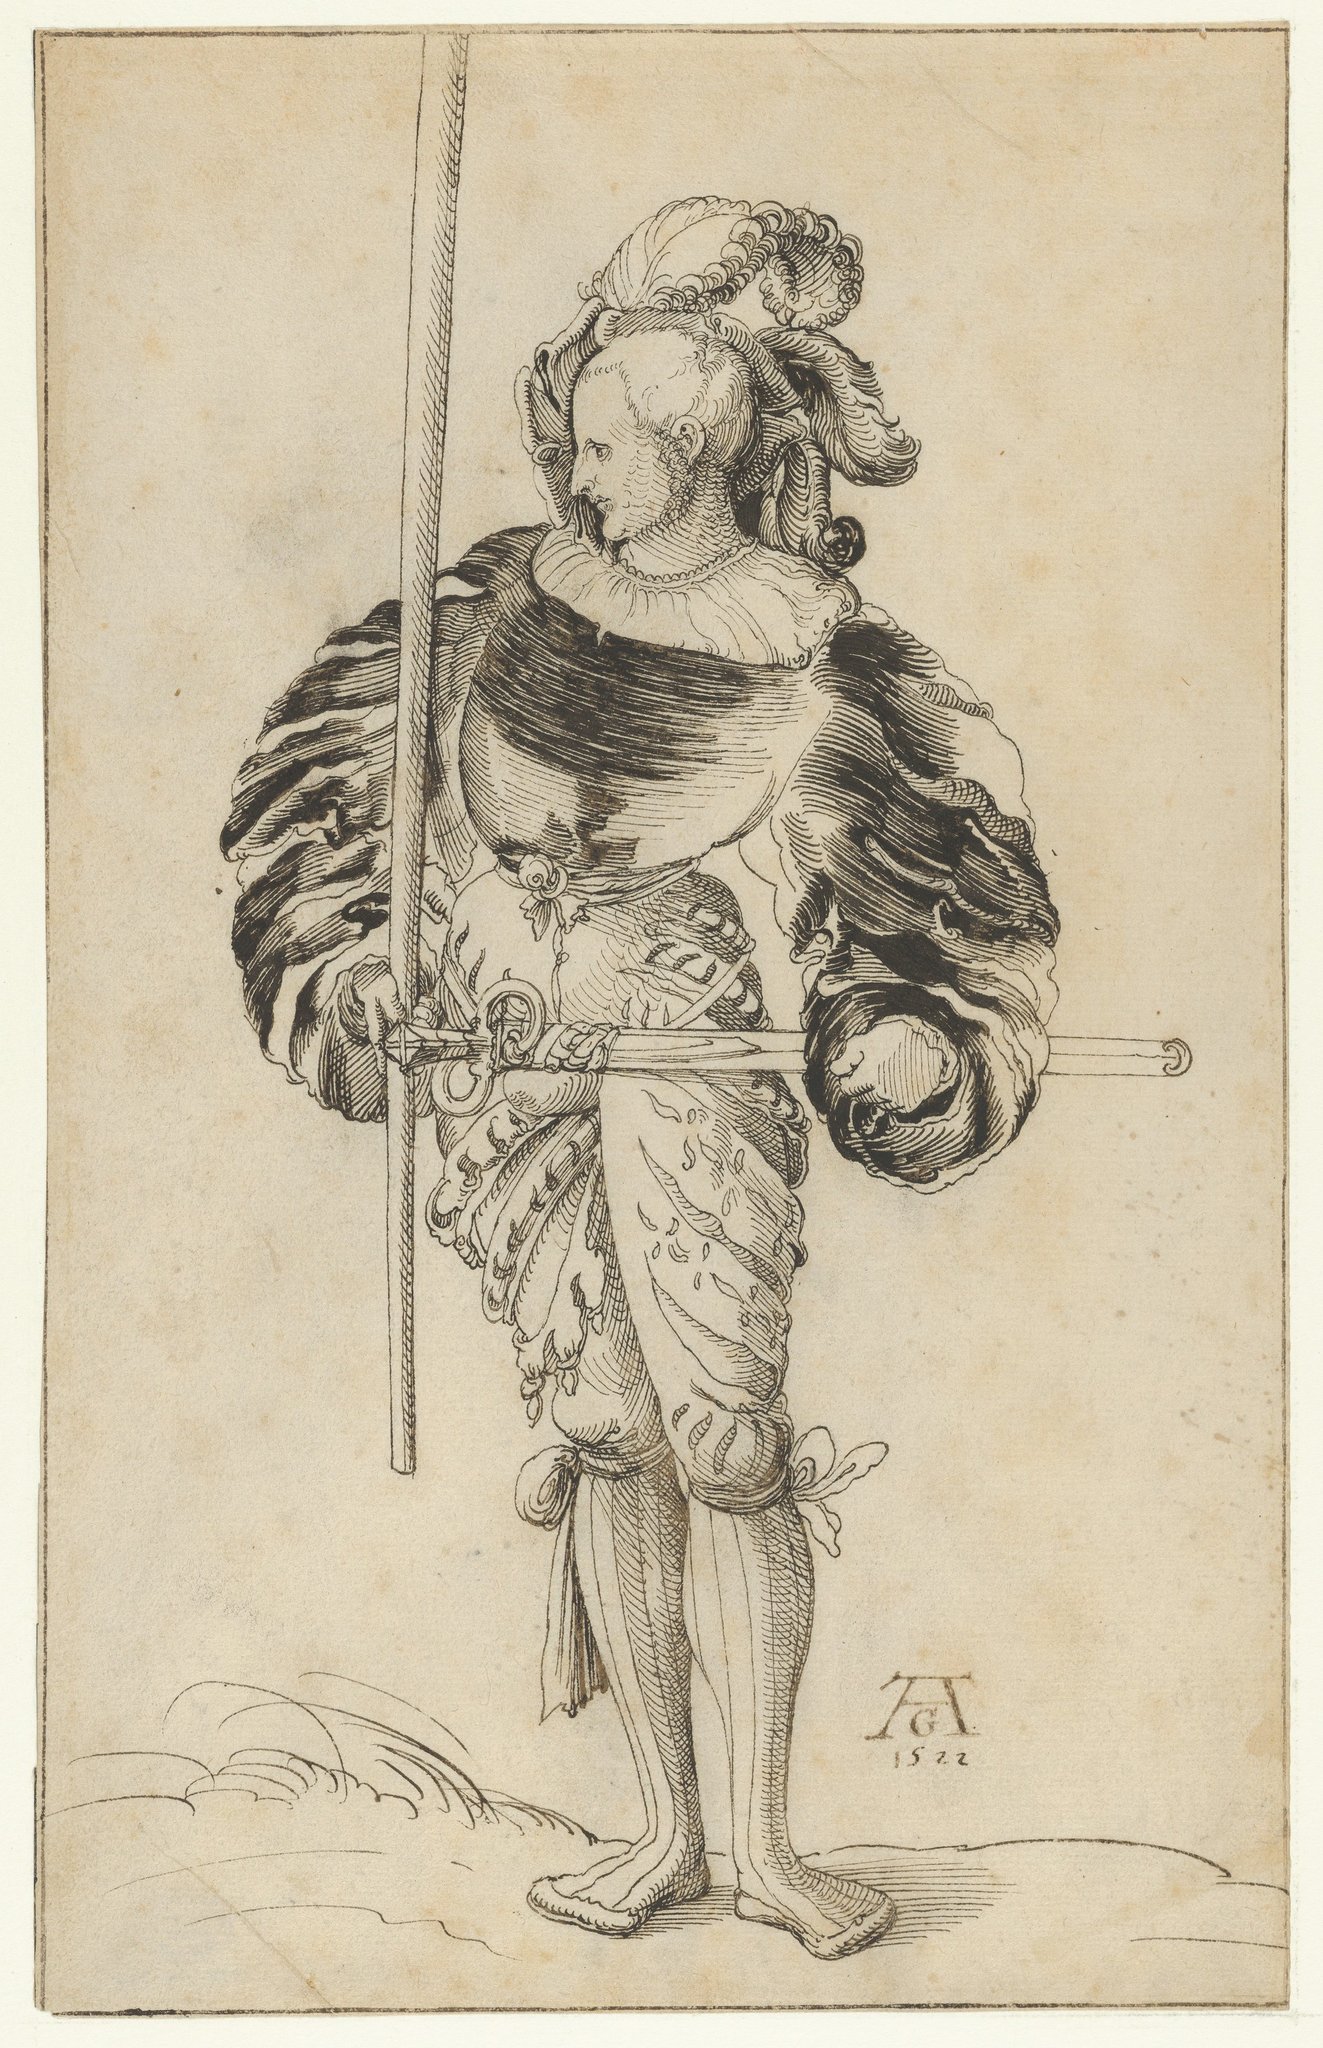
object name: drawing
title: A Swiss Foot Soldier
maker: niklaus manuel deutsch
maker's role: artist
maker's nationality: swiss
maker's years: 1484-1530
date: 1501-1533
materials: ink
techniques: pen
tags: soldiers,swords,men